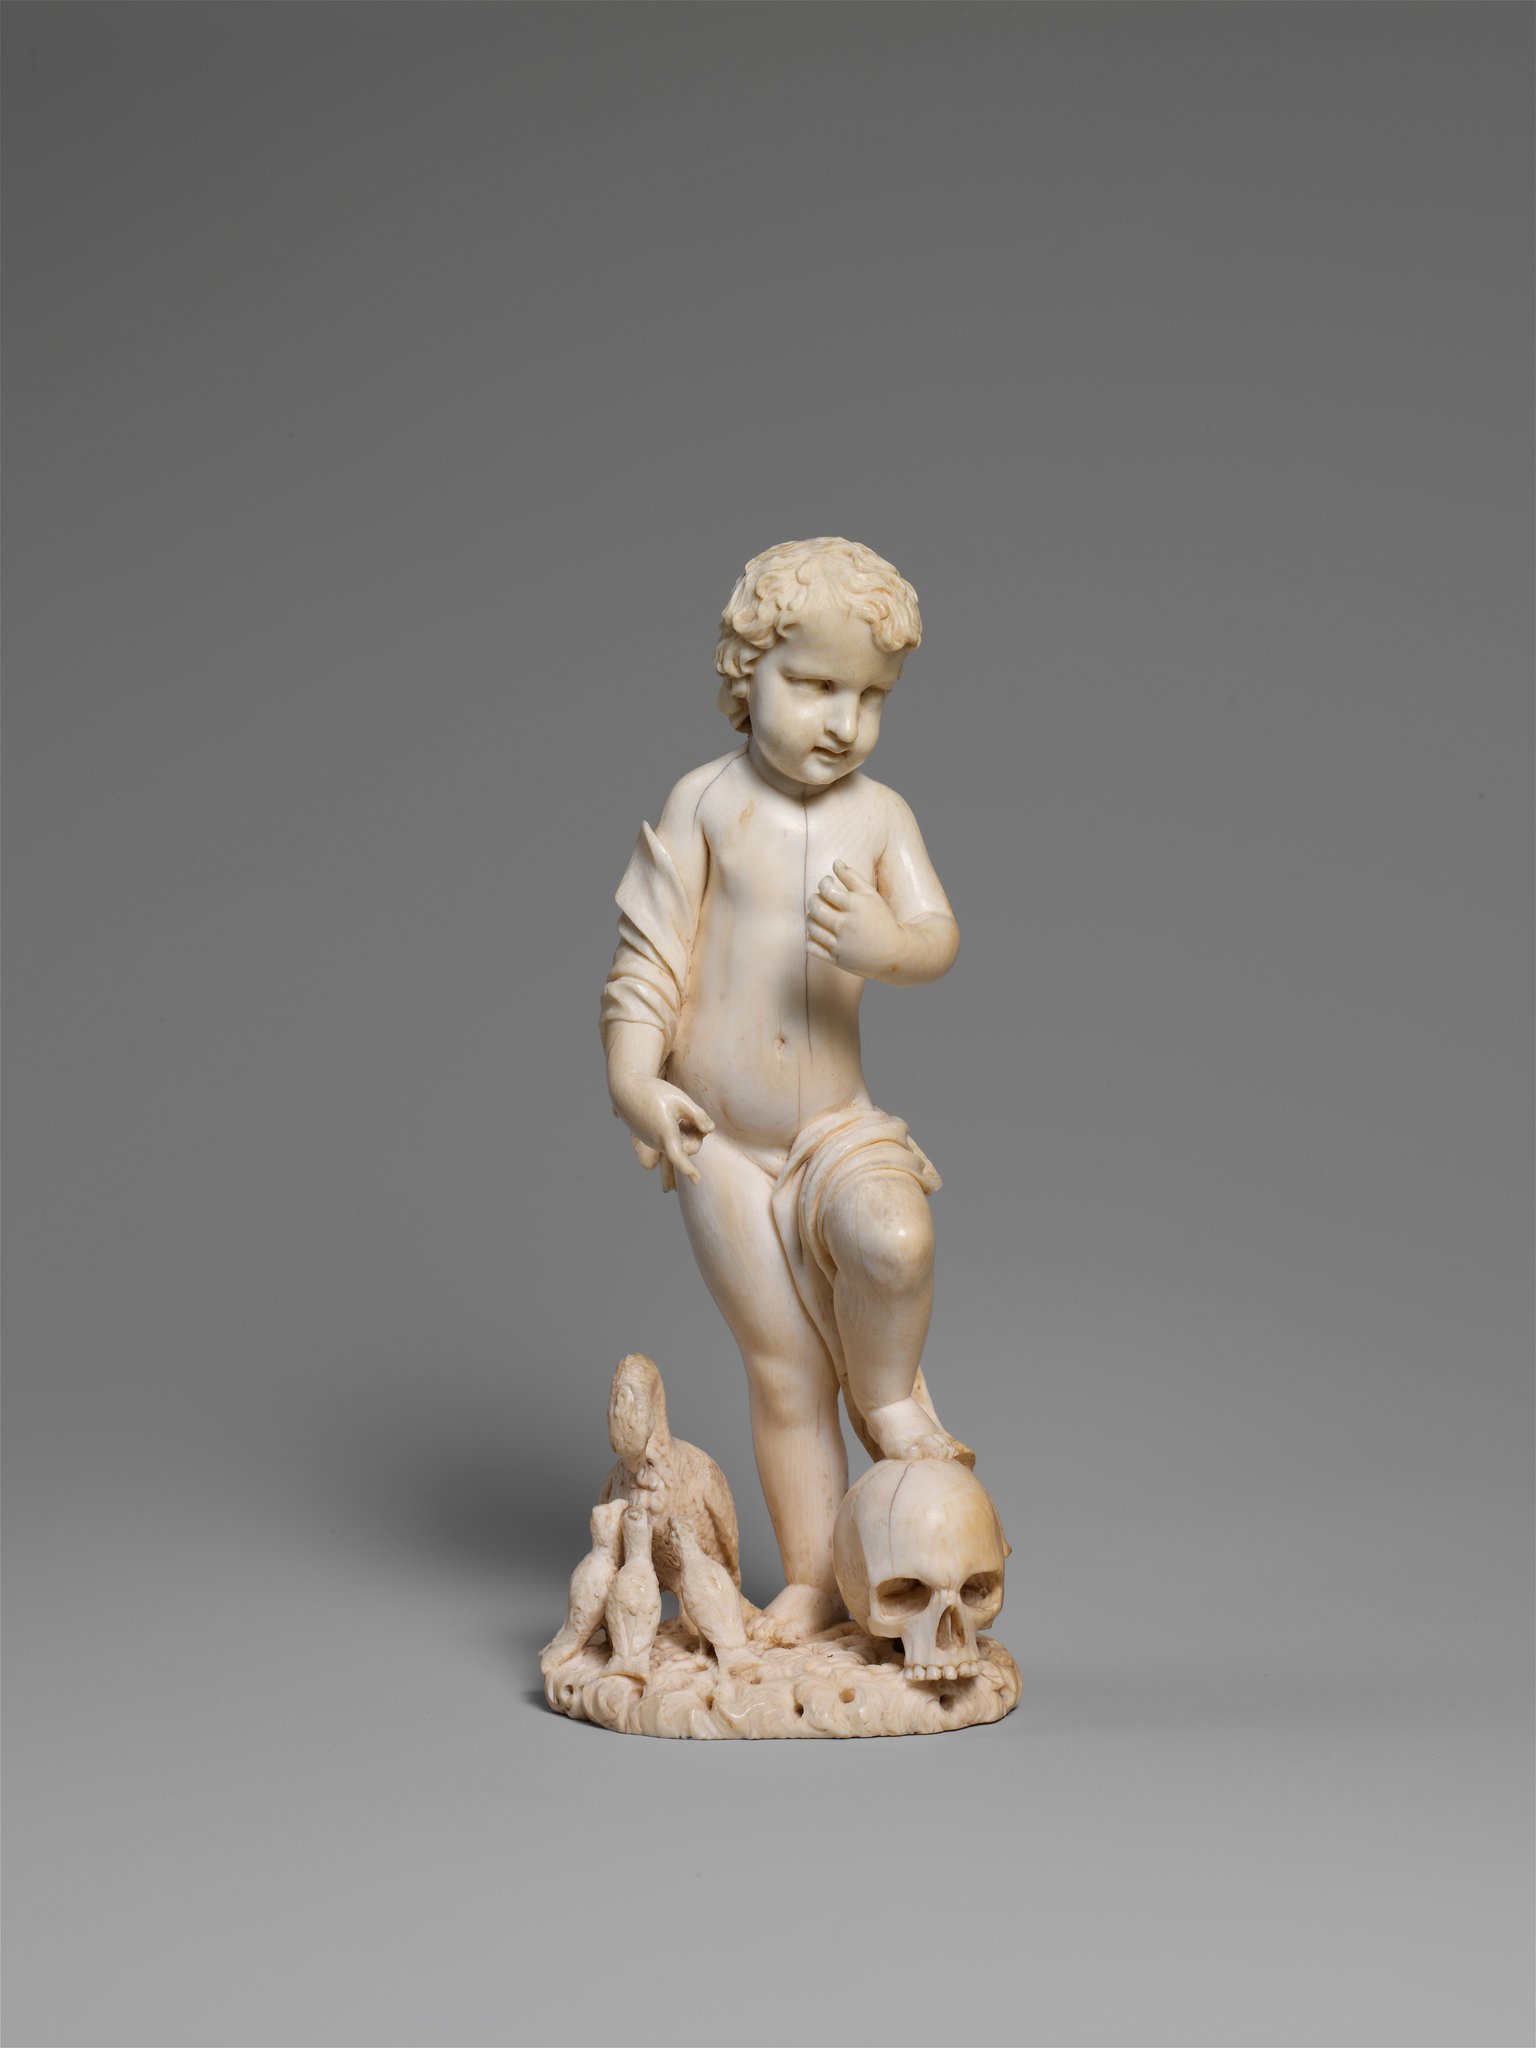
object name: statuette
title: Christ Child with Pelicans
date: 1701-1800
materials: ivory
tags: skulls,pelicans,christ